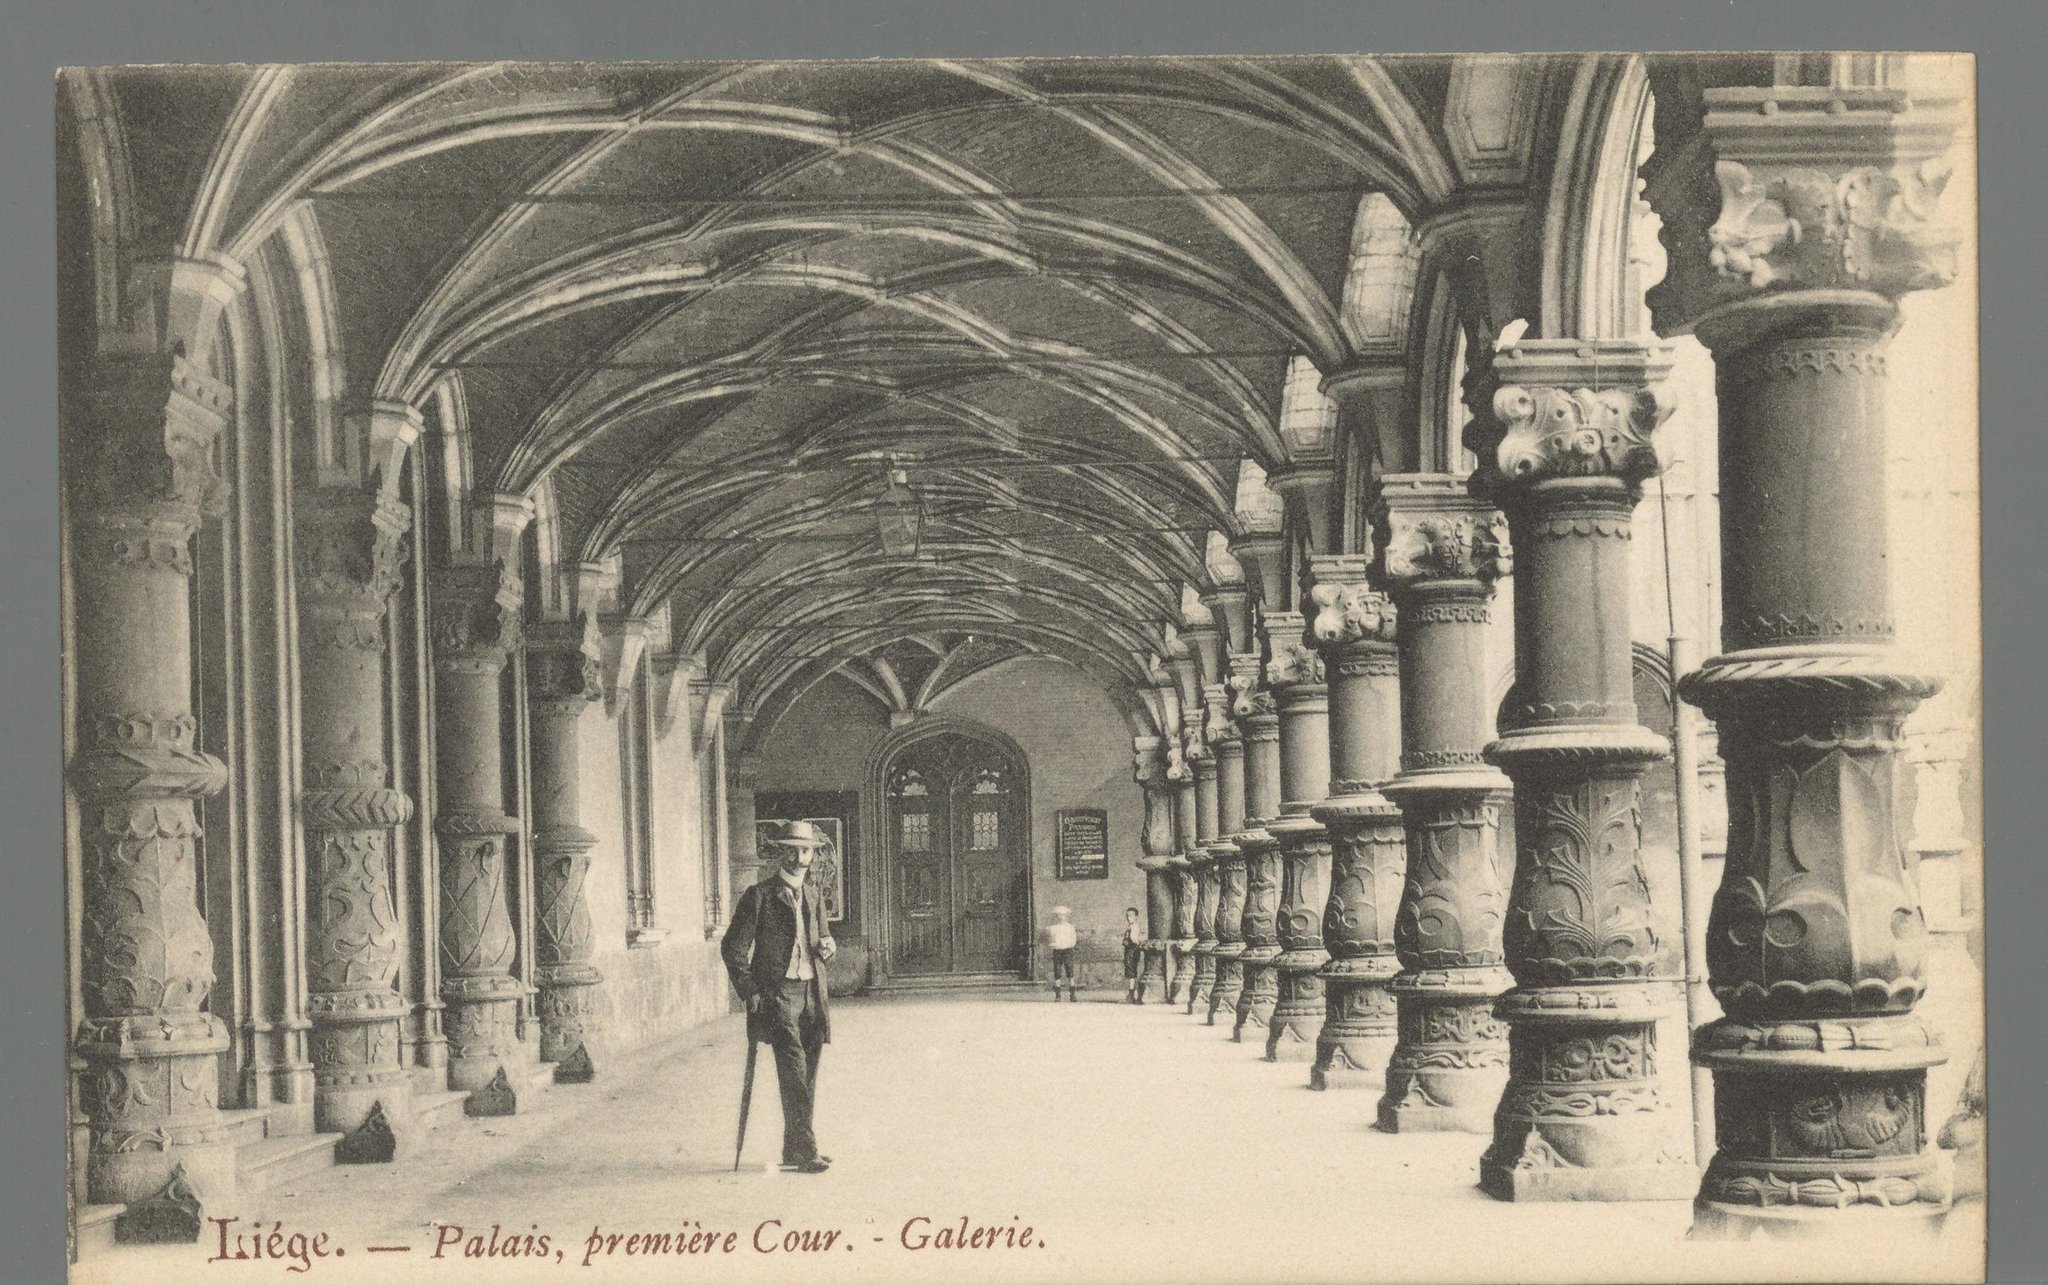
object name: photomechanical print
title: Liège. Palais, première Cour. Galerie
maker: Anonymous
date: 1906-1930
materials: cardboard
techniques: photograph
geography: liège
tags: courtyard